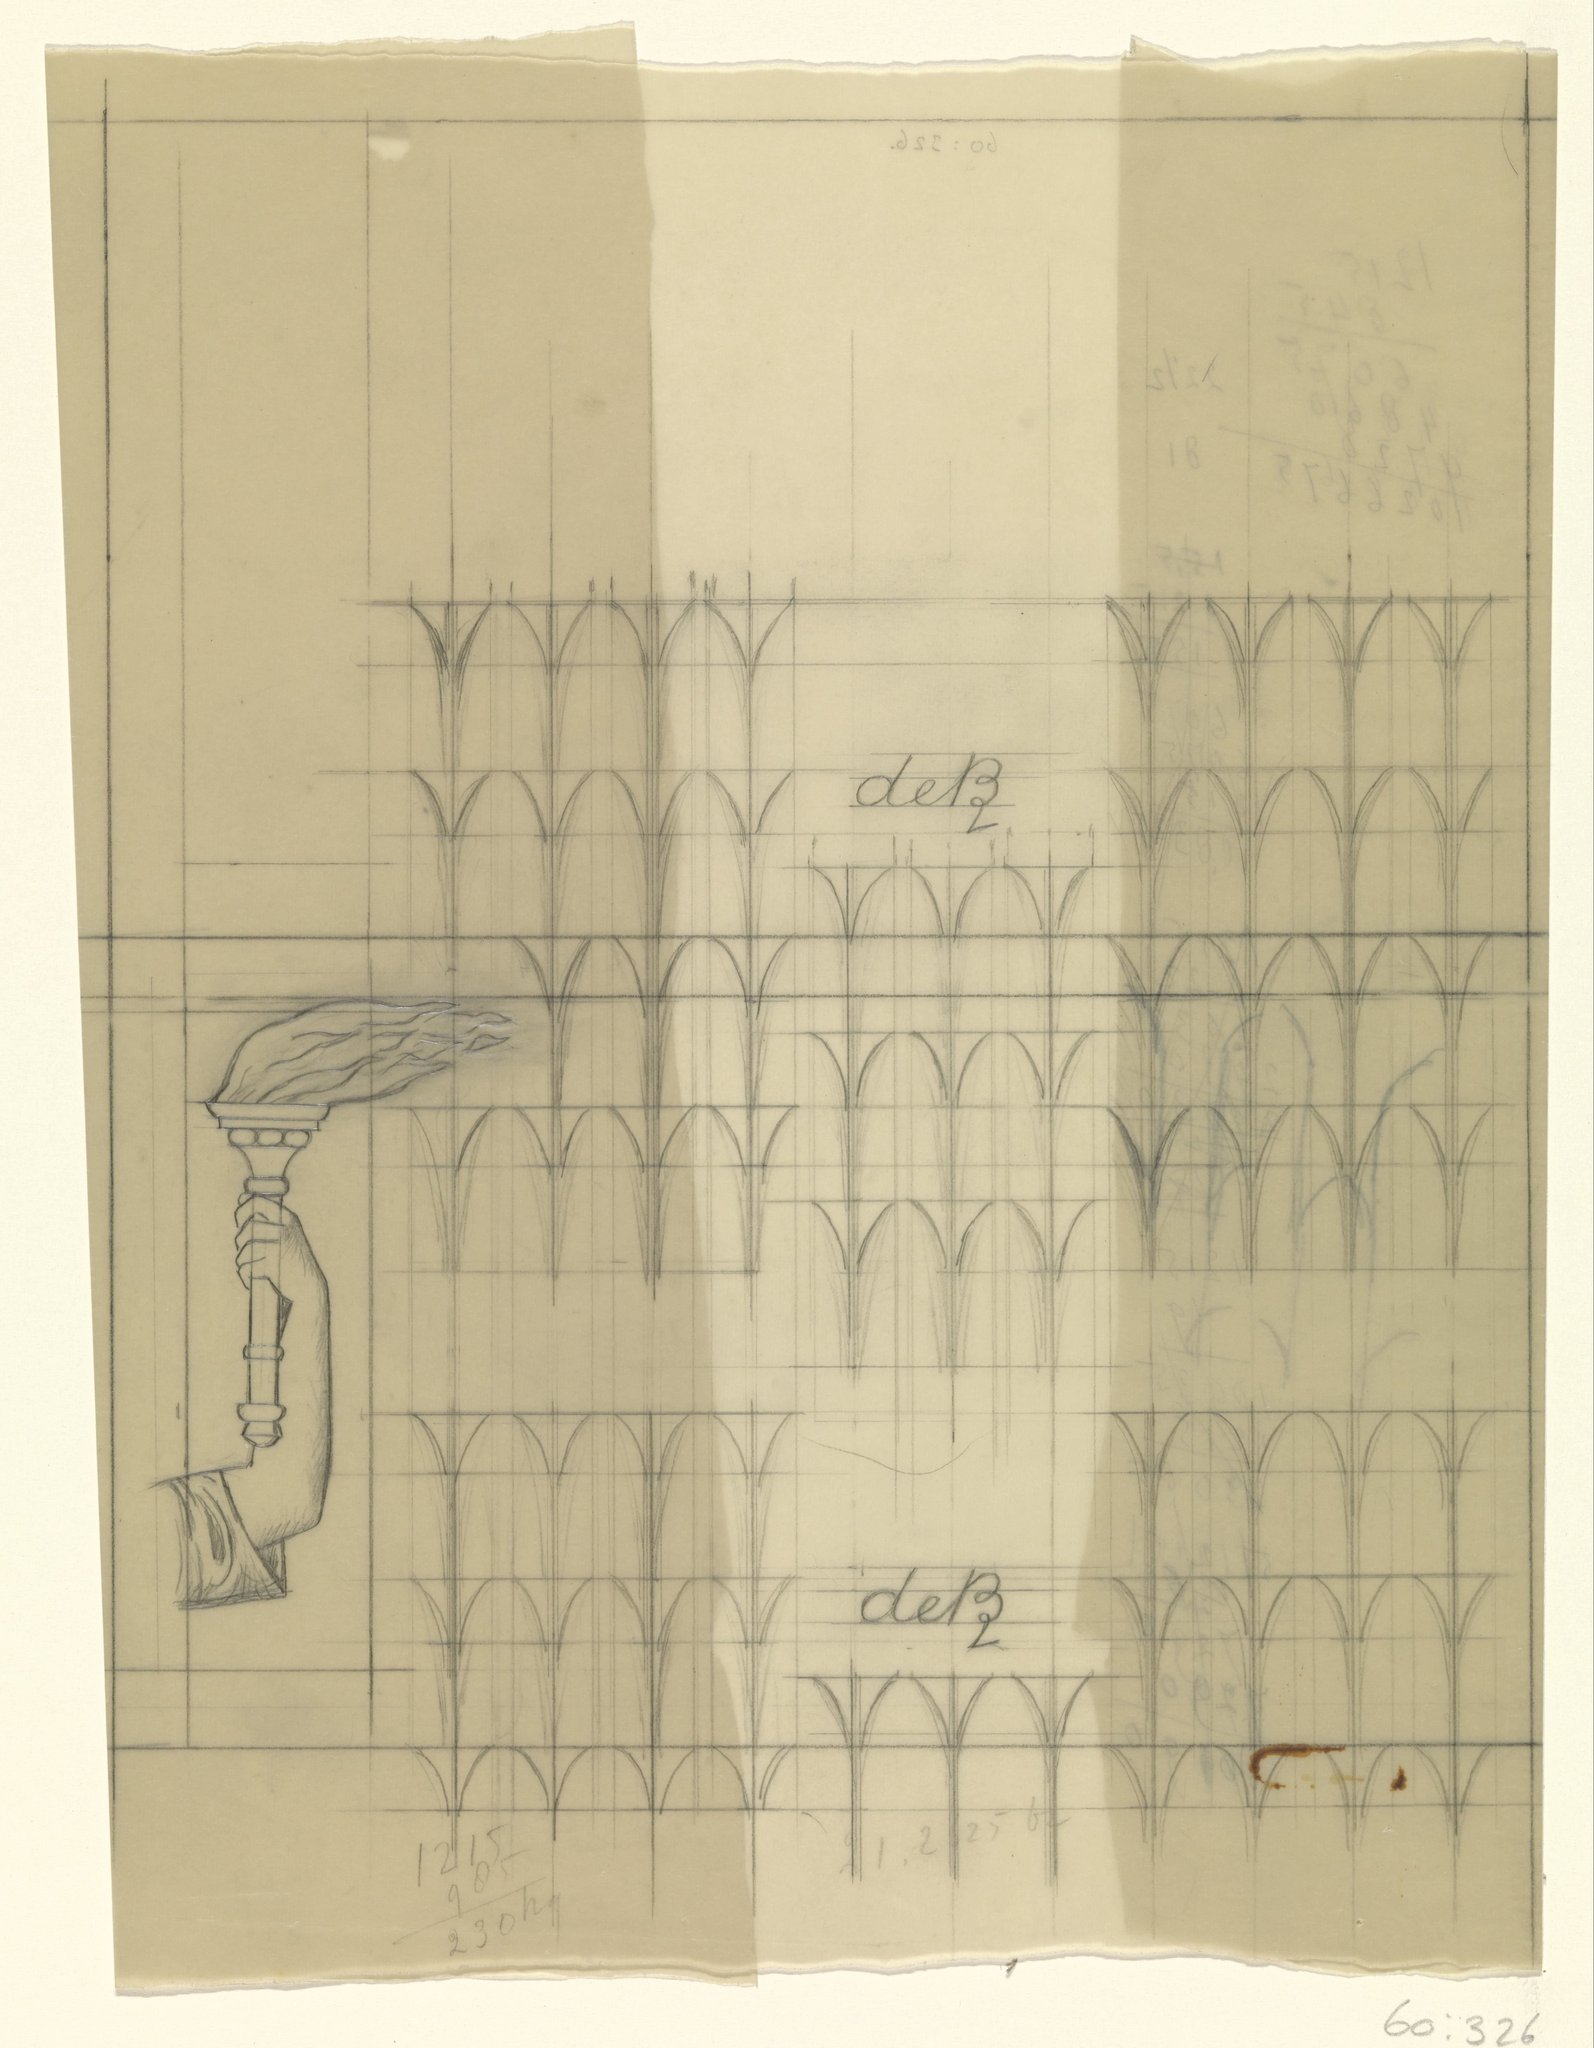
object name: design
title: Hand met een fakkel en boogstructuren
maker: leo gestel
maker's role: draughtsman, print maker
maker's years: 1881-1941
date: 1939-1941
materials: pencil, paper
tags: torch, lower arm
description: Ontwerp voor een watermerk voor een bankbiljet.